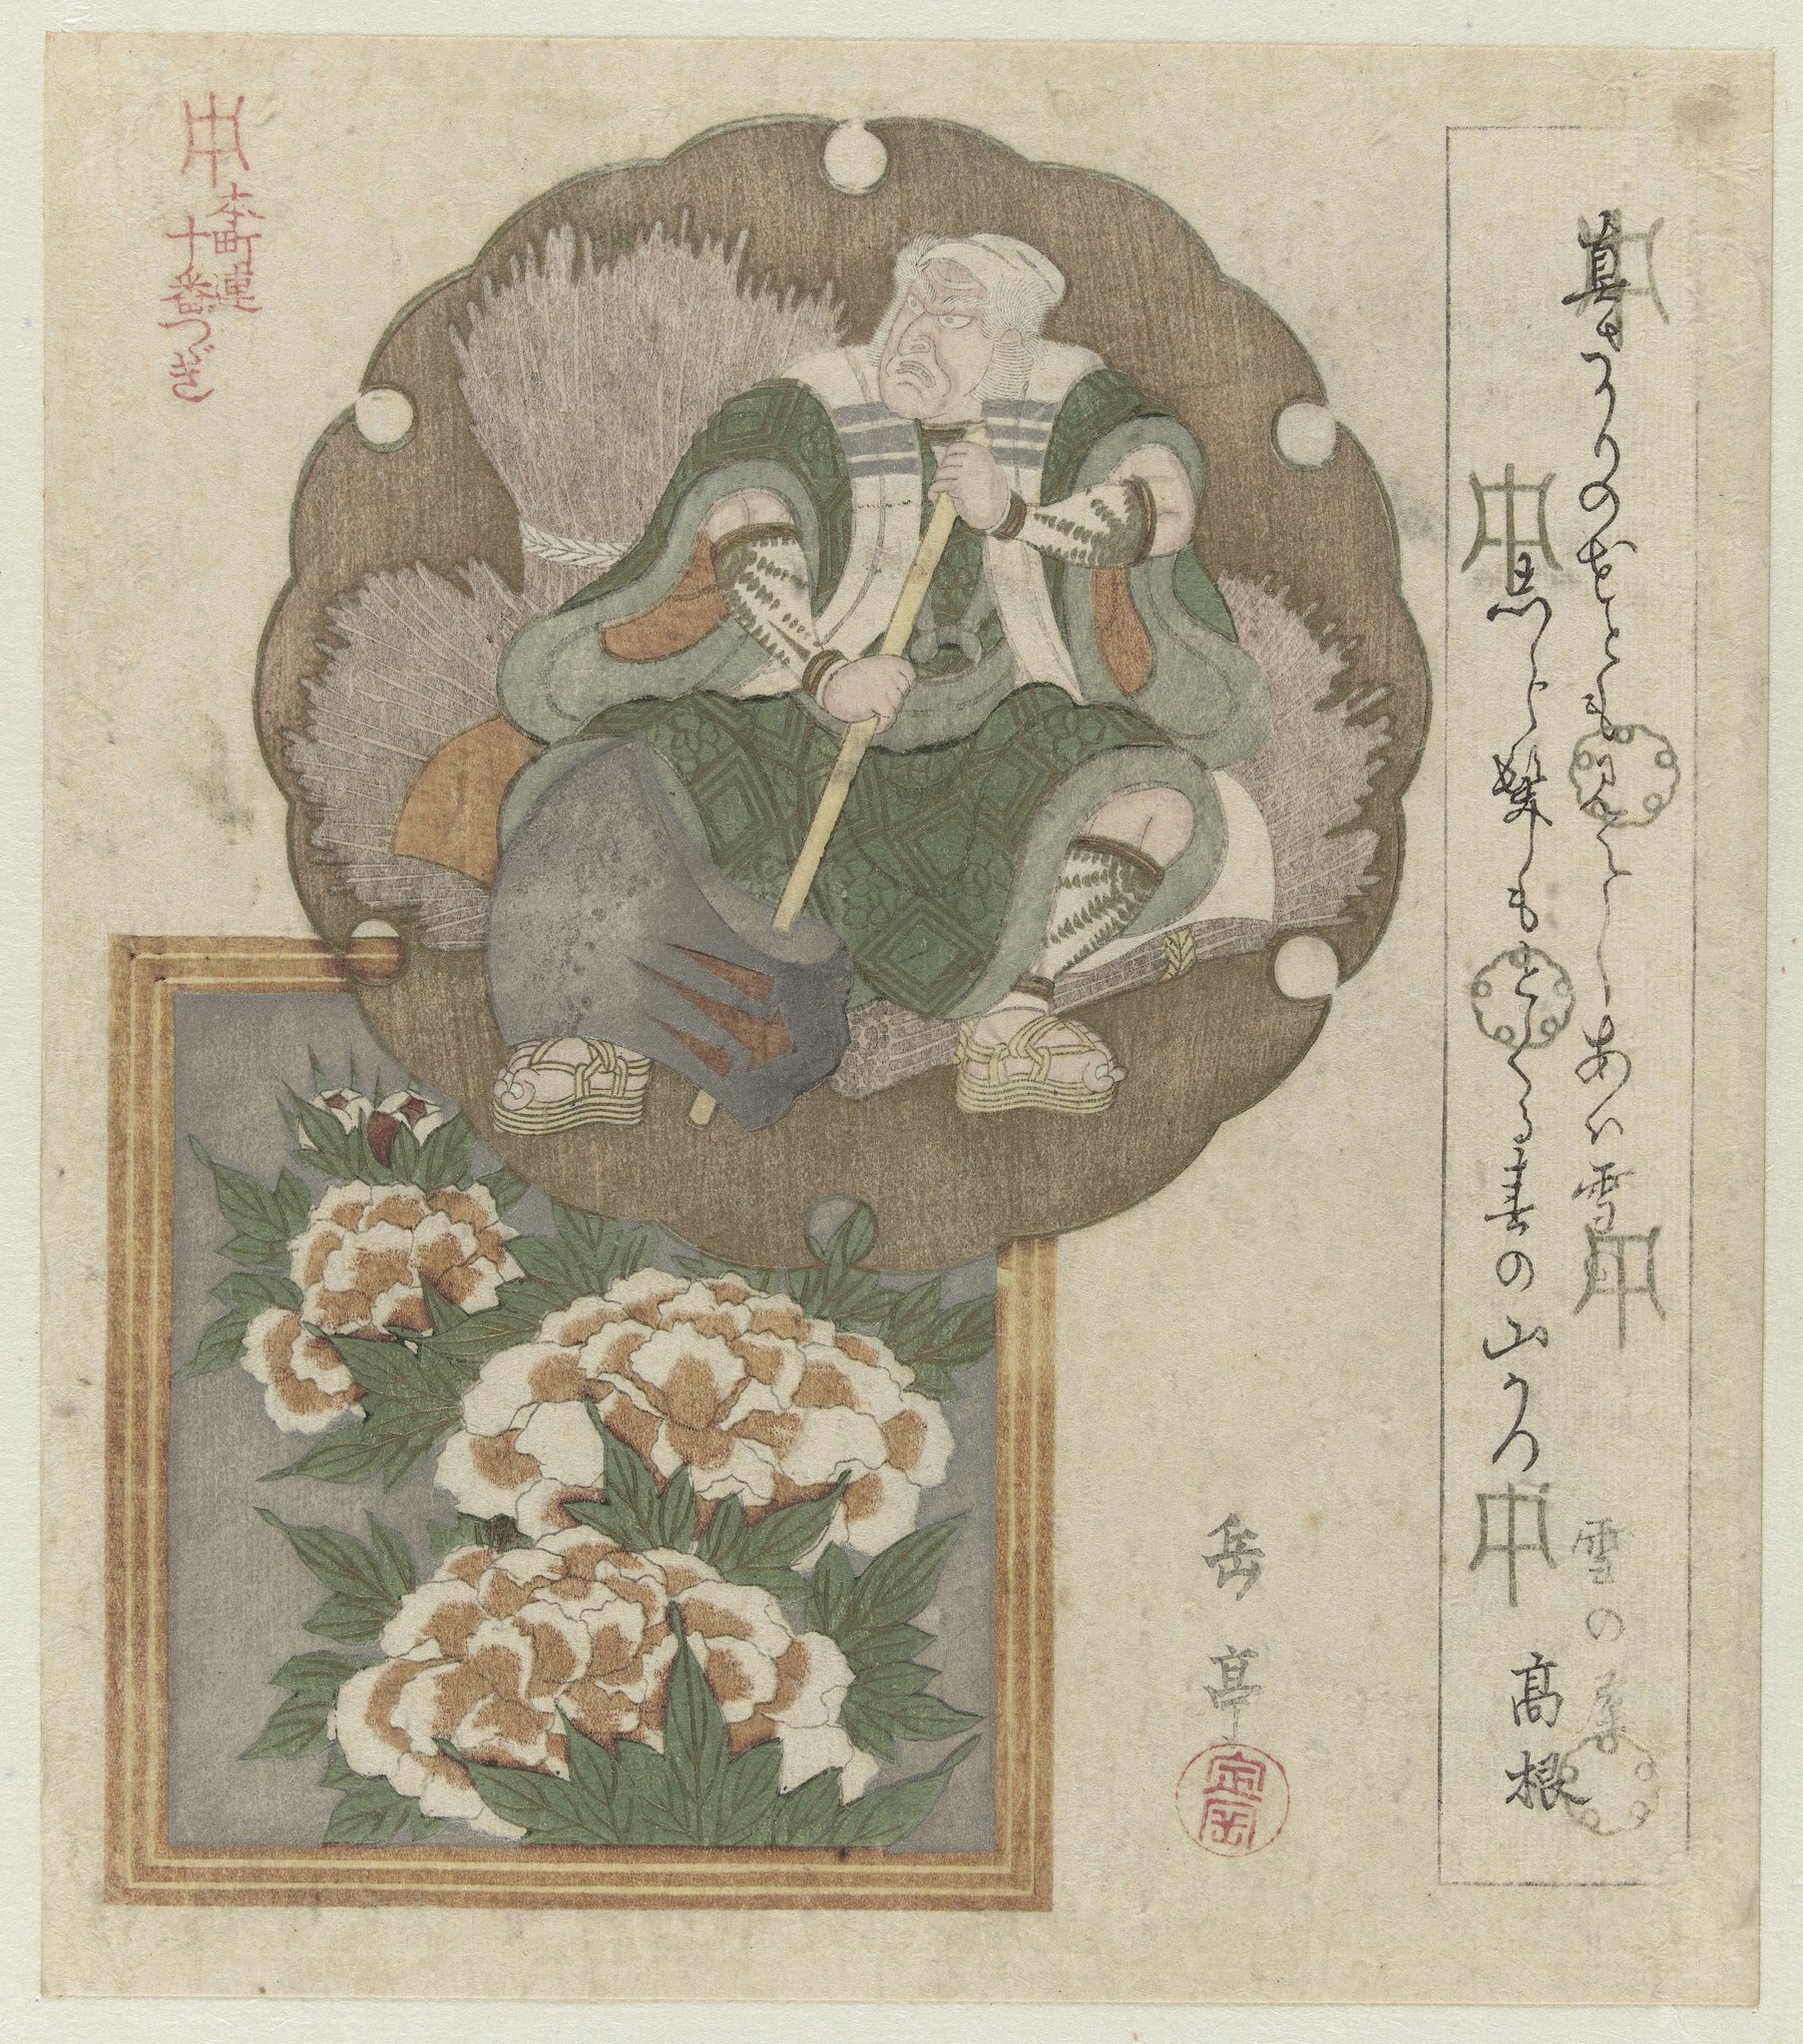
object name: surimono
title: Een serie van tien prenten voor de Honchôren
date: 1822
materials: paper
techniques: blind stamped, woodcut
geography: japan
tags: plants and herbs: peony, actor (on the stage)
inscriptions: collector's mark, passe-partout, bottom left, printed: JABdH with a rooster., collector's mark, verso, stamped: Lugt 2228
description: Een surimono is een luxe uitgevoerde prent waarop beeld met één of meerdere gedichten gecombineerd is. Bij het drukken van een surimono werd vaak gebruik gemaakt van dikker papier, blinddruk en metaal pigmenten, zoals koper- en zilverpoeder. De prenten werden vaak in opdracht van dichters gemaakt en als exclusief geschenk aan vrienden en relaties gegeven.